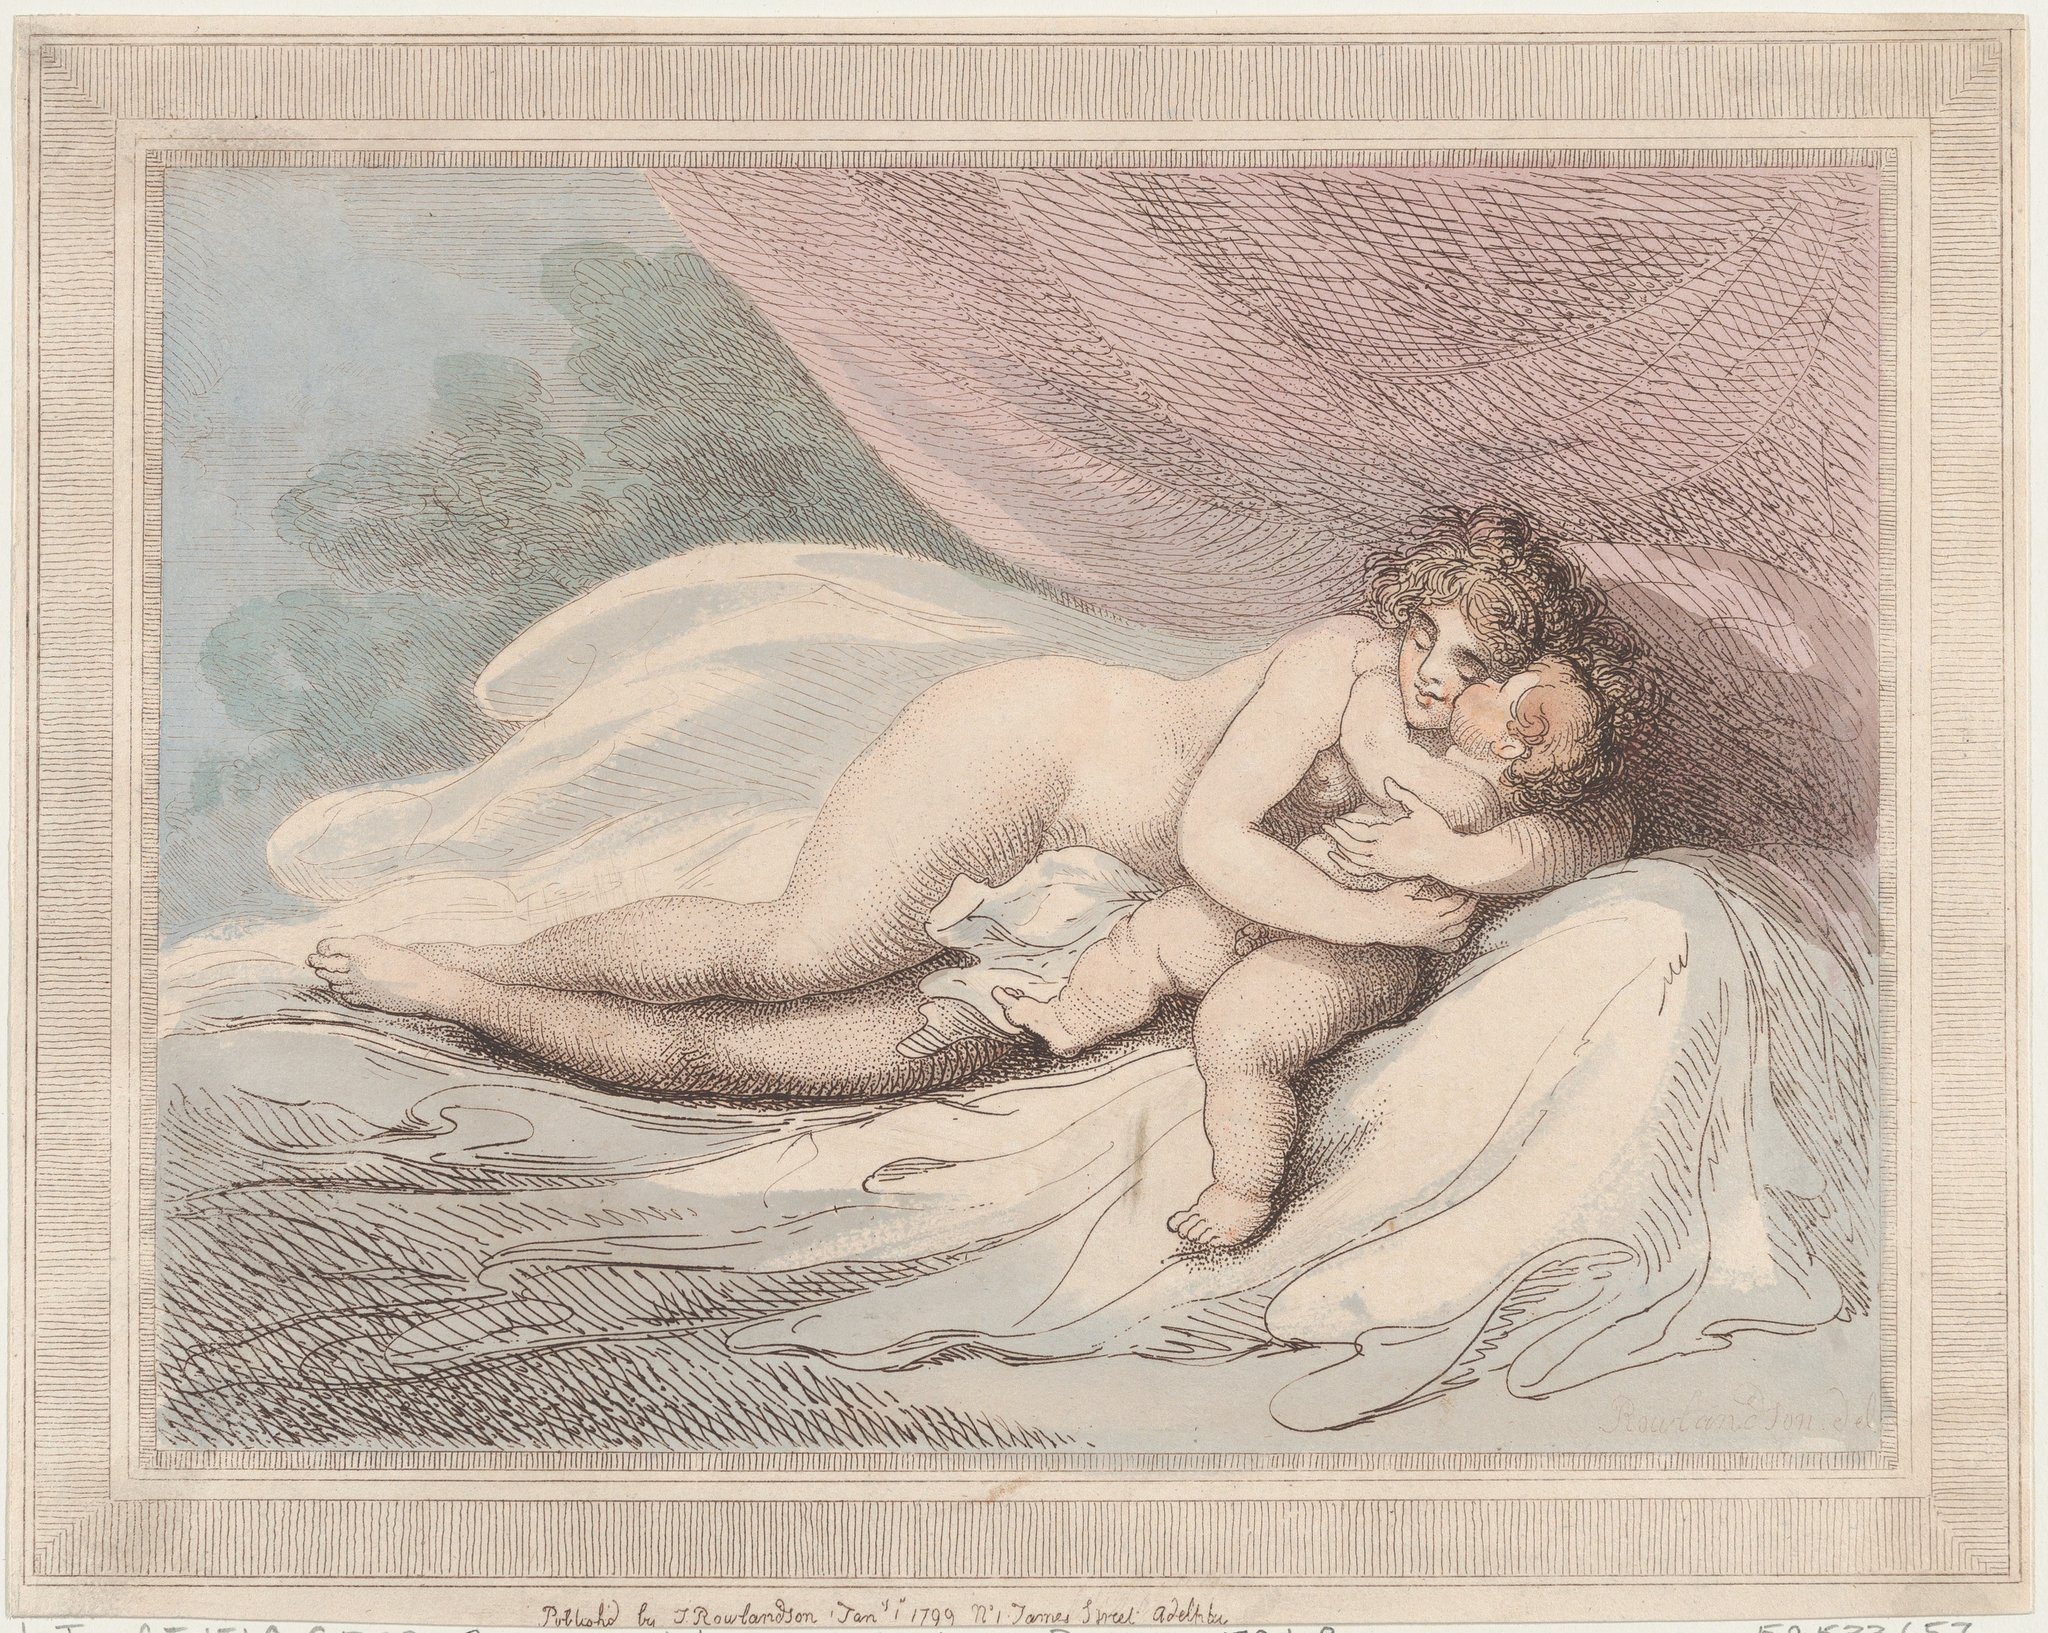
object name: print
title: Sleeping Venus Cuddling a Child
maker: thomas rowlandson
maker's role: artist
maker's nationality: british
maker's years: 1757-1827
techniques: etching, hand coloring, stippling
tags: infants,female nudes